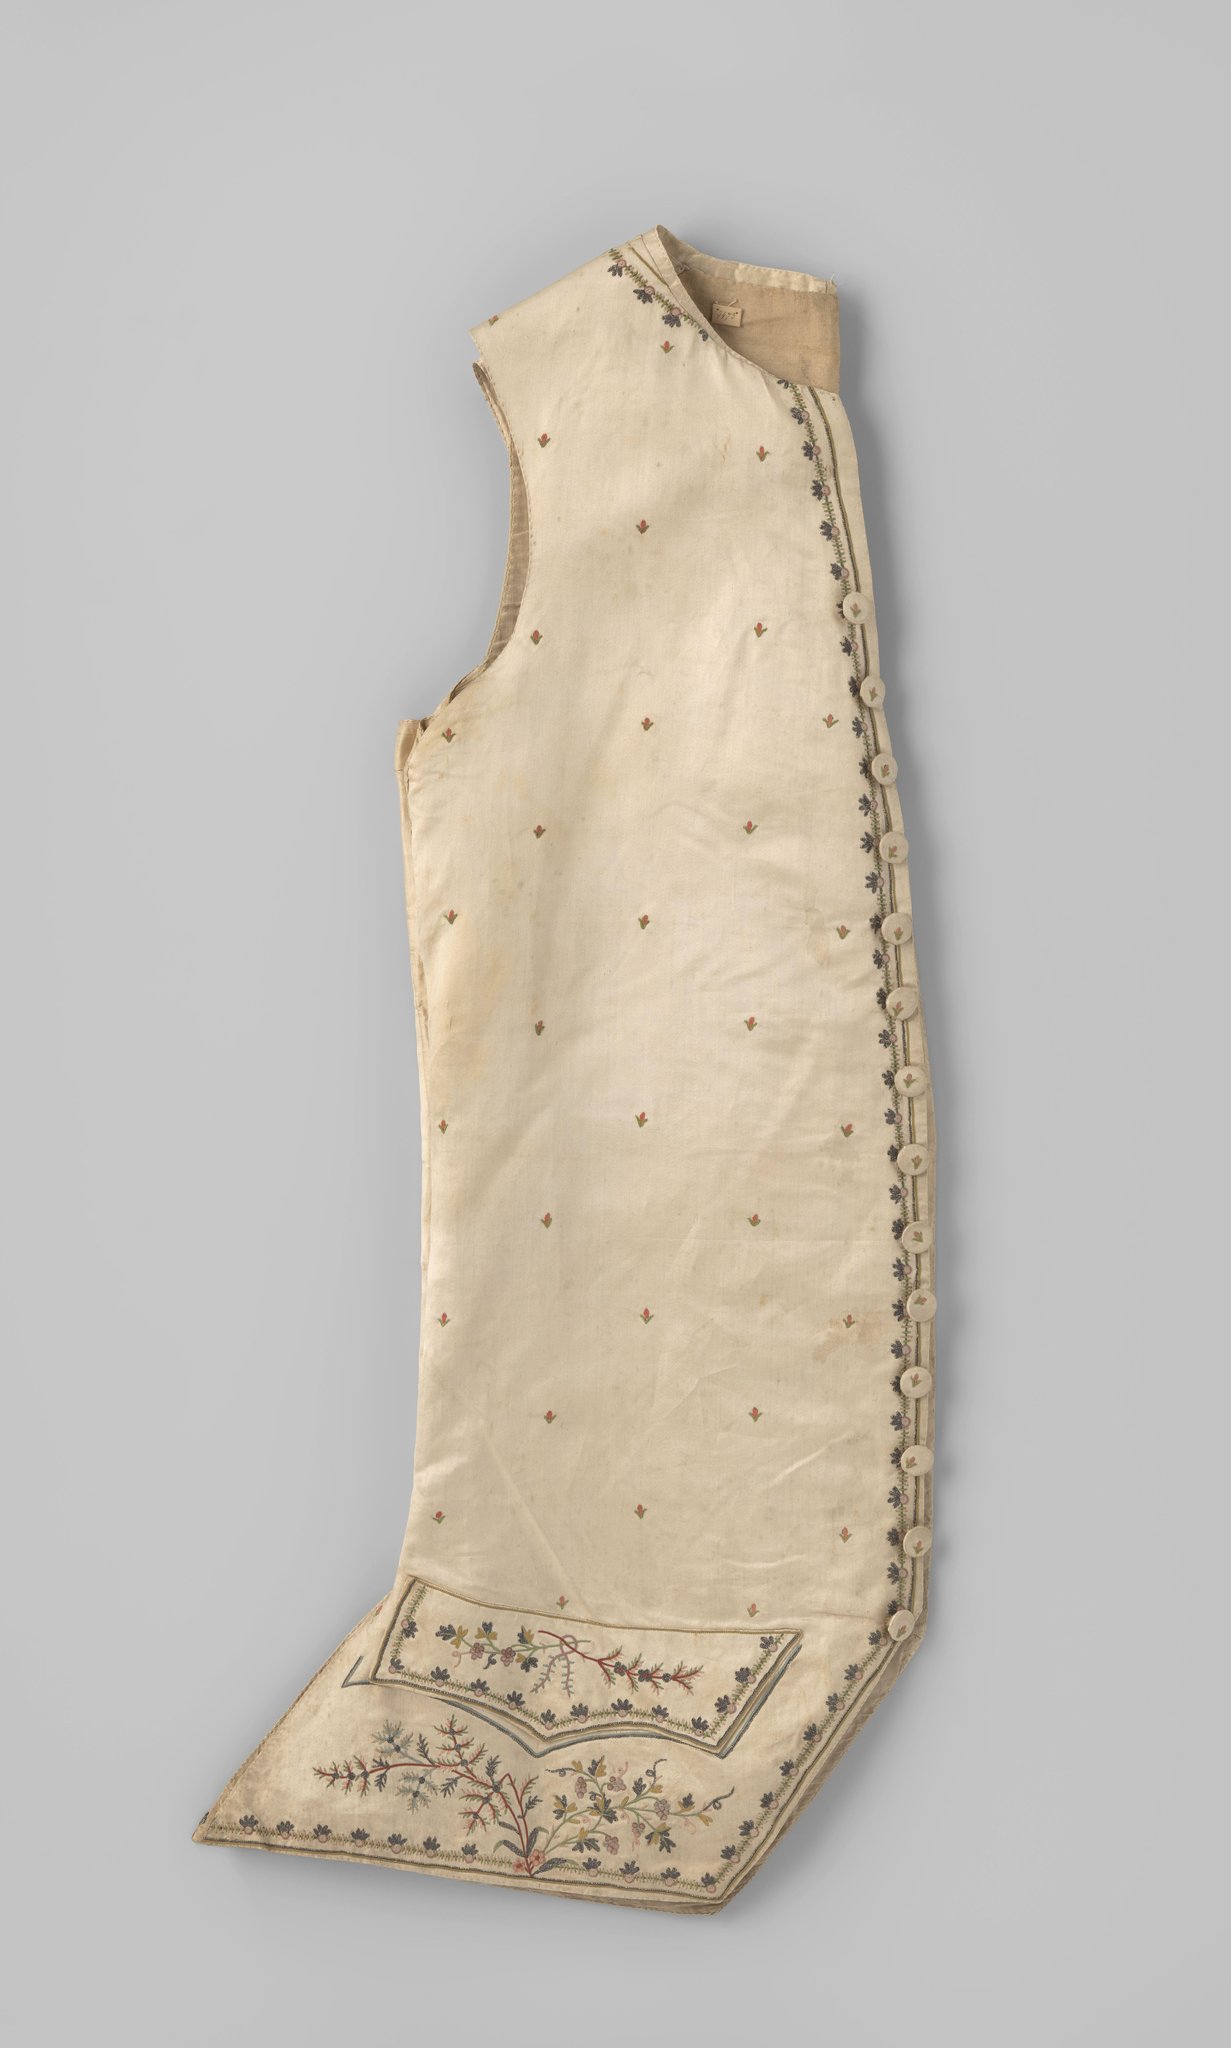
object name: clothing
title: Lang mouwloos vest van crème satijn, met spaarzaam bloemmotief in groen en oranje en meerkleurige florale randmotieven met metaaldraad; rug van linnen en flanel.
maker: Anonymous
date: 1770-1780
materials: textile, linen, silk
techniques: embroidered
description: Vest van wit zijde. Kleine bloemen en rand van zilverdraad en zijde. Veelkleurig strooipatroon in tamboereerwerk. Geen kraag. Voering van zijde, linnen en flanel.